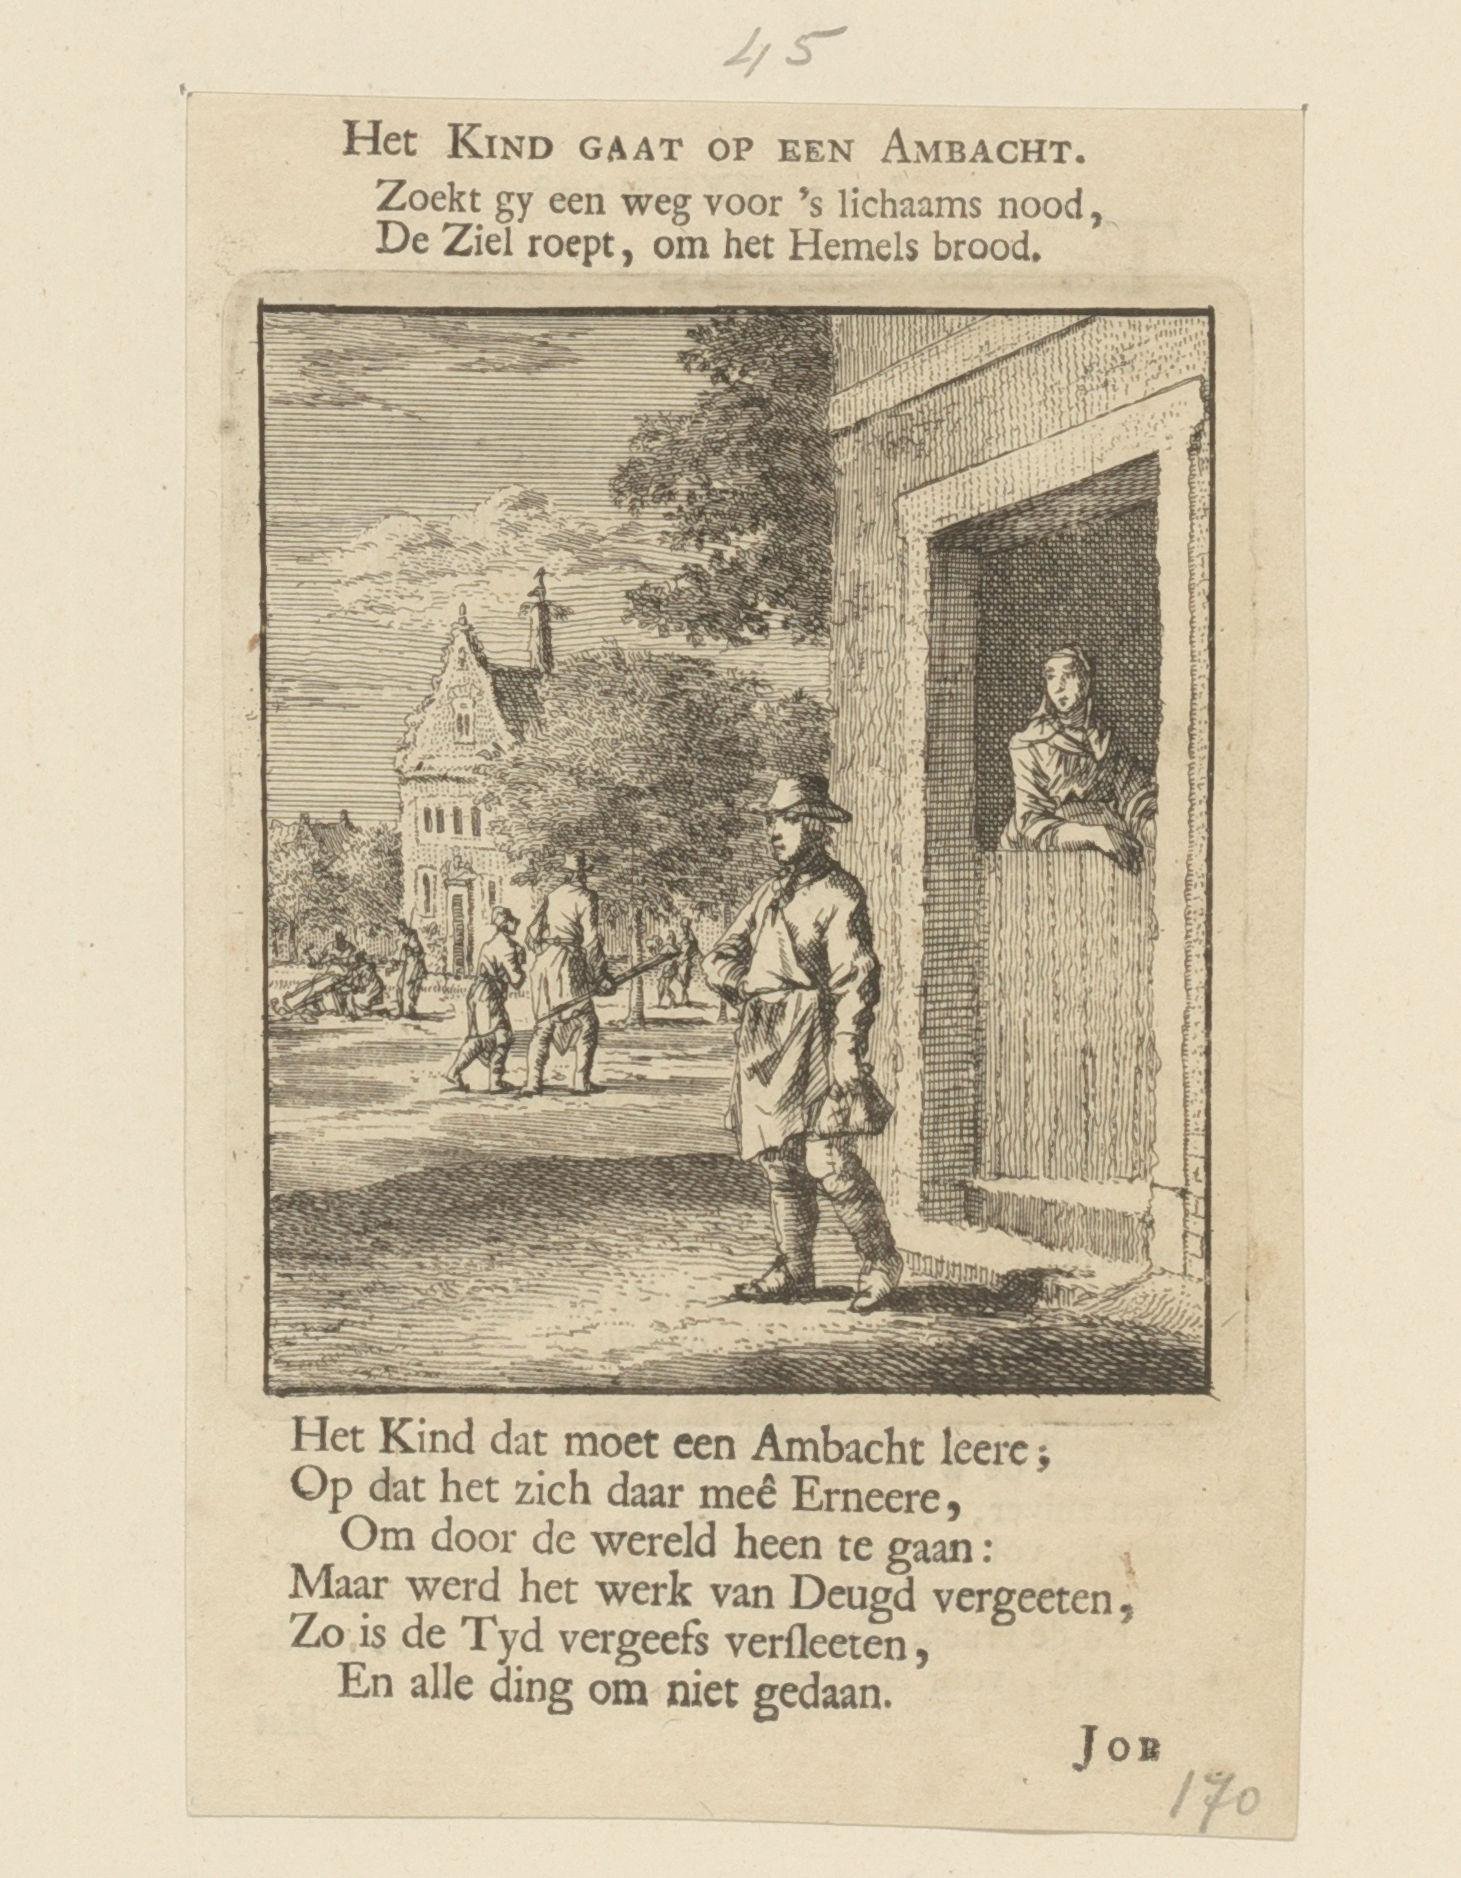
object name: print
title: Kind op weg om een ambacht te leren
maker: jan luyken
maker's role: draughtsman, print maker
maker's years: 1649-1712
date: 1712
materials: paper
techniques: etching, letterpress printing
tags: handicrafts, craftsman at work, student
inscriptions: stamp, collector's mark: Lugt 1641, stamp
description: Onderaan een zesregelig vers. Onderwerpsrubrieken binnen de Atlas Zeden en Gewoonten: Zeden en Gewoonten in Engeren Zin, Des menschen beging, midden en einde, Kinderleven – Kinderspel en Kinderprenten.